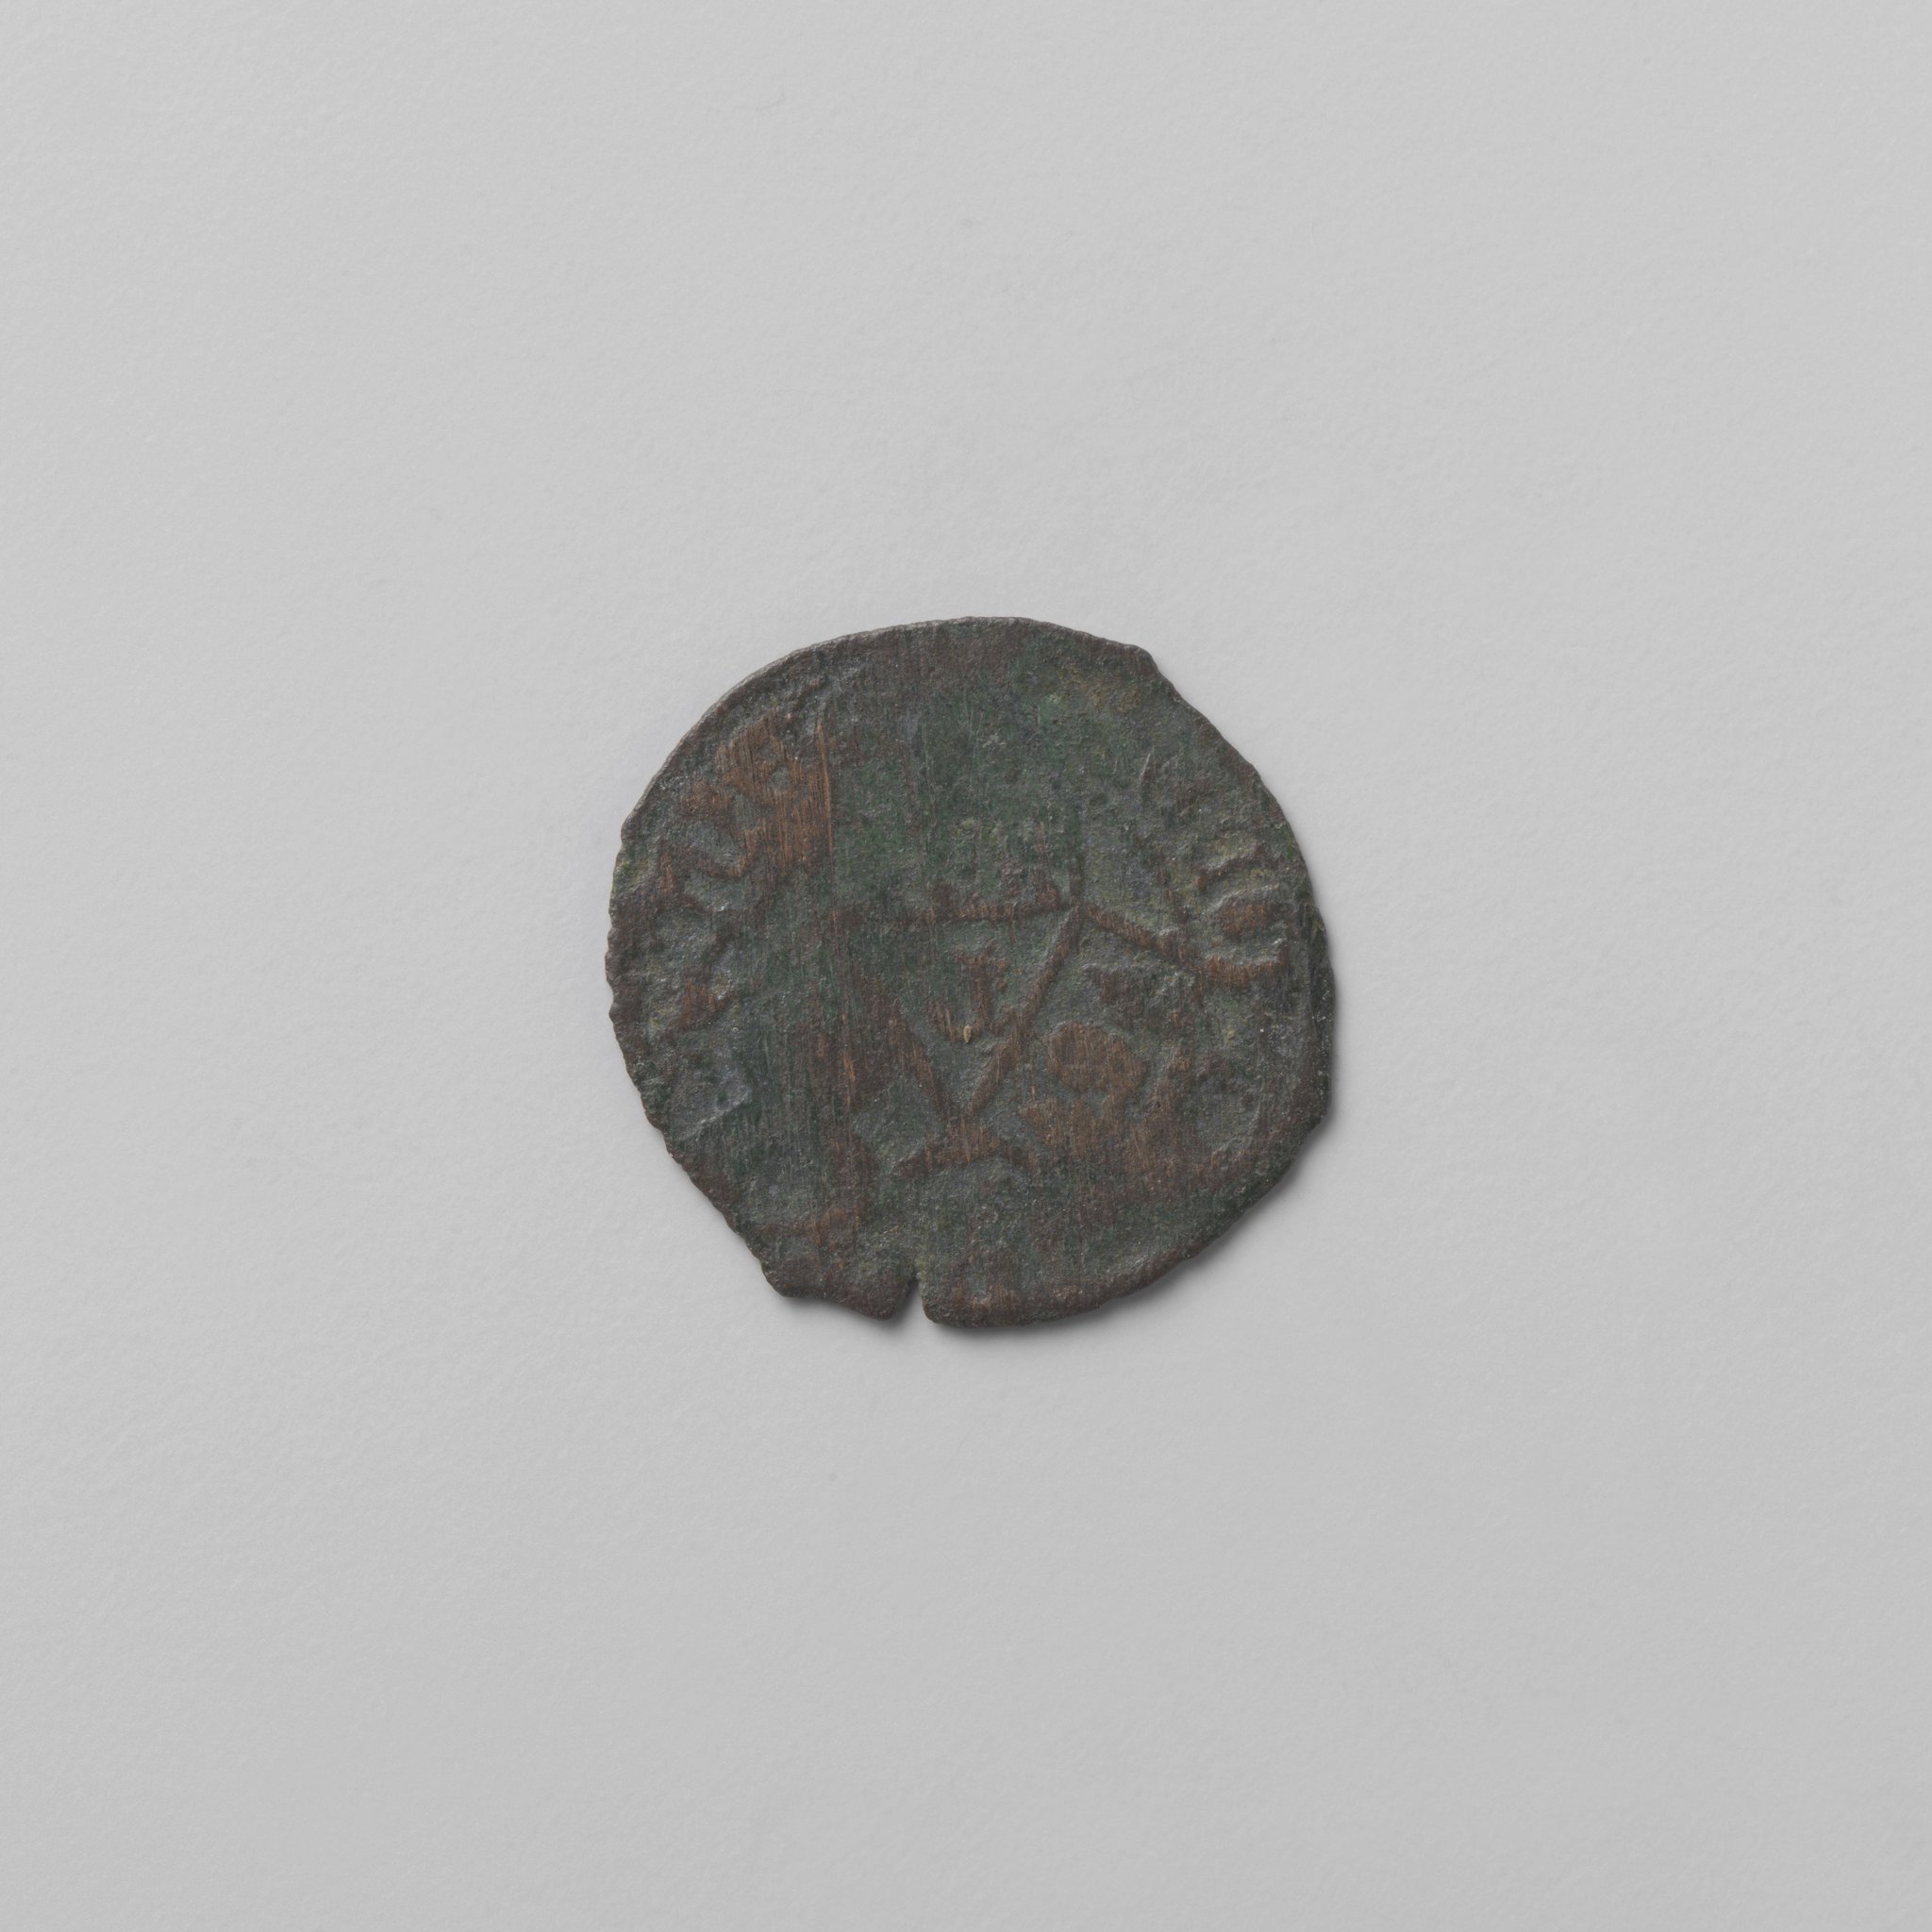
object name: coin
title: Drie Steden, halve plak, 1561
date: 1561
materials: silver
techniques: striking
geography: deventer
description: Koper-zilveren munt. Voorzijde: versierd lang kruis. In het centrum een ster. Keerzijde: wapenschilden van de Drie Steden, in het centrum letter D. Jaartal in omschrift.